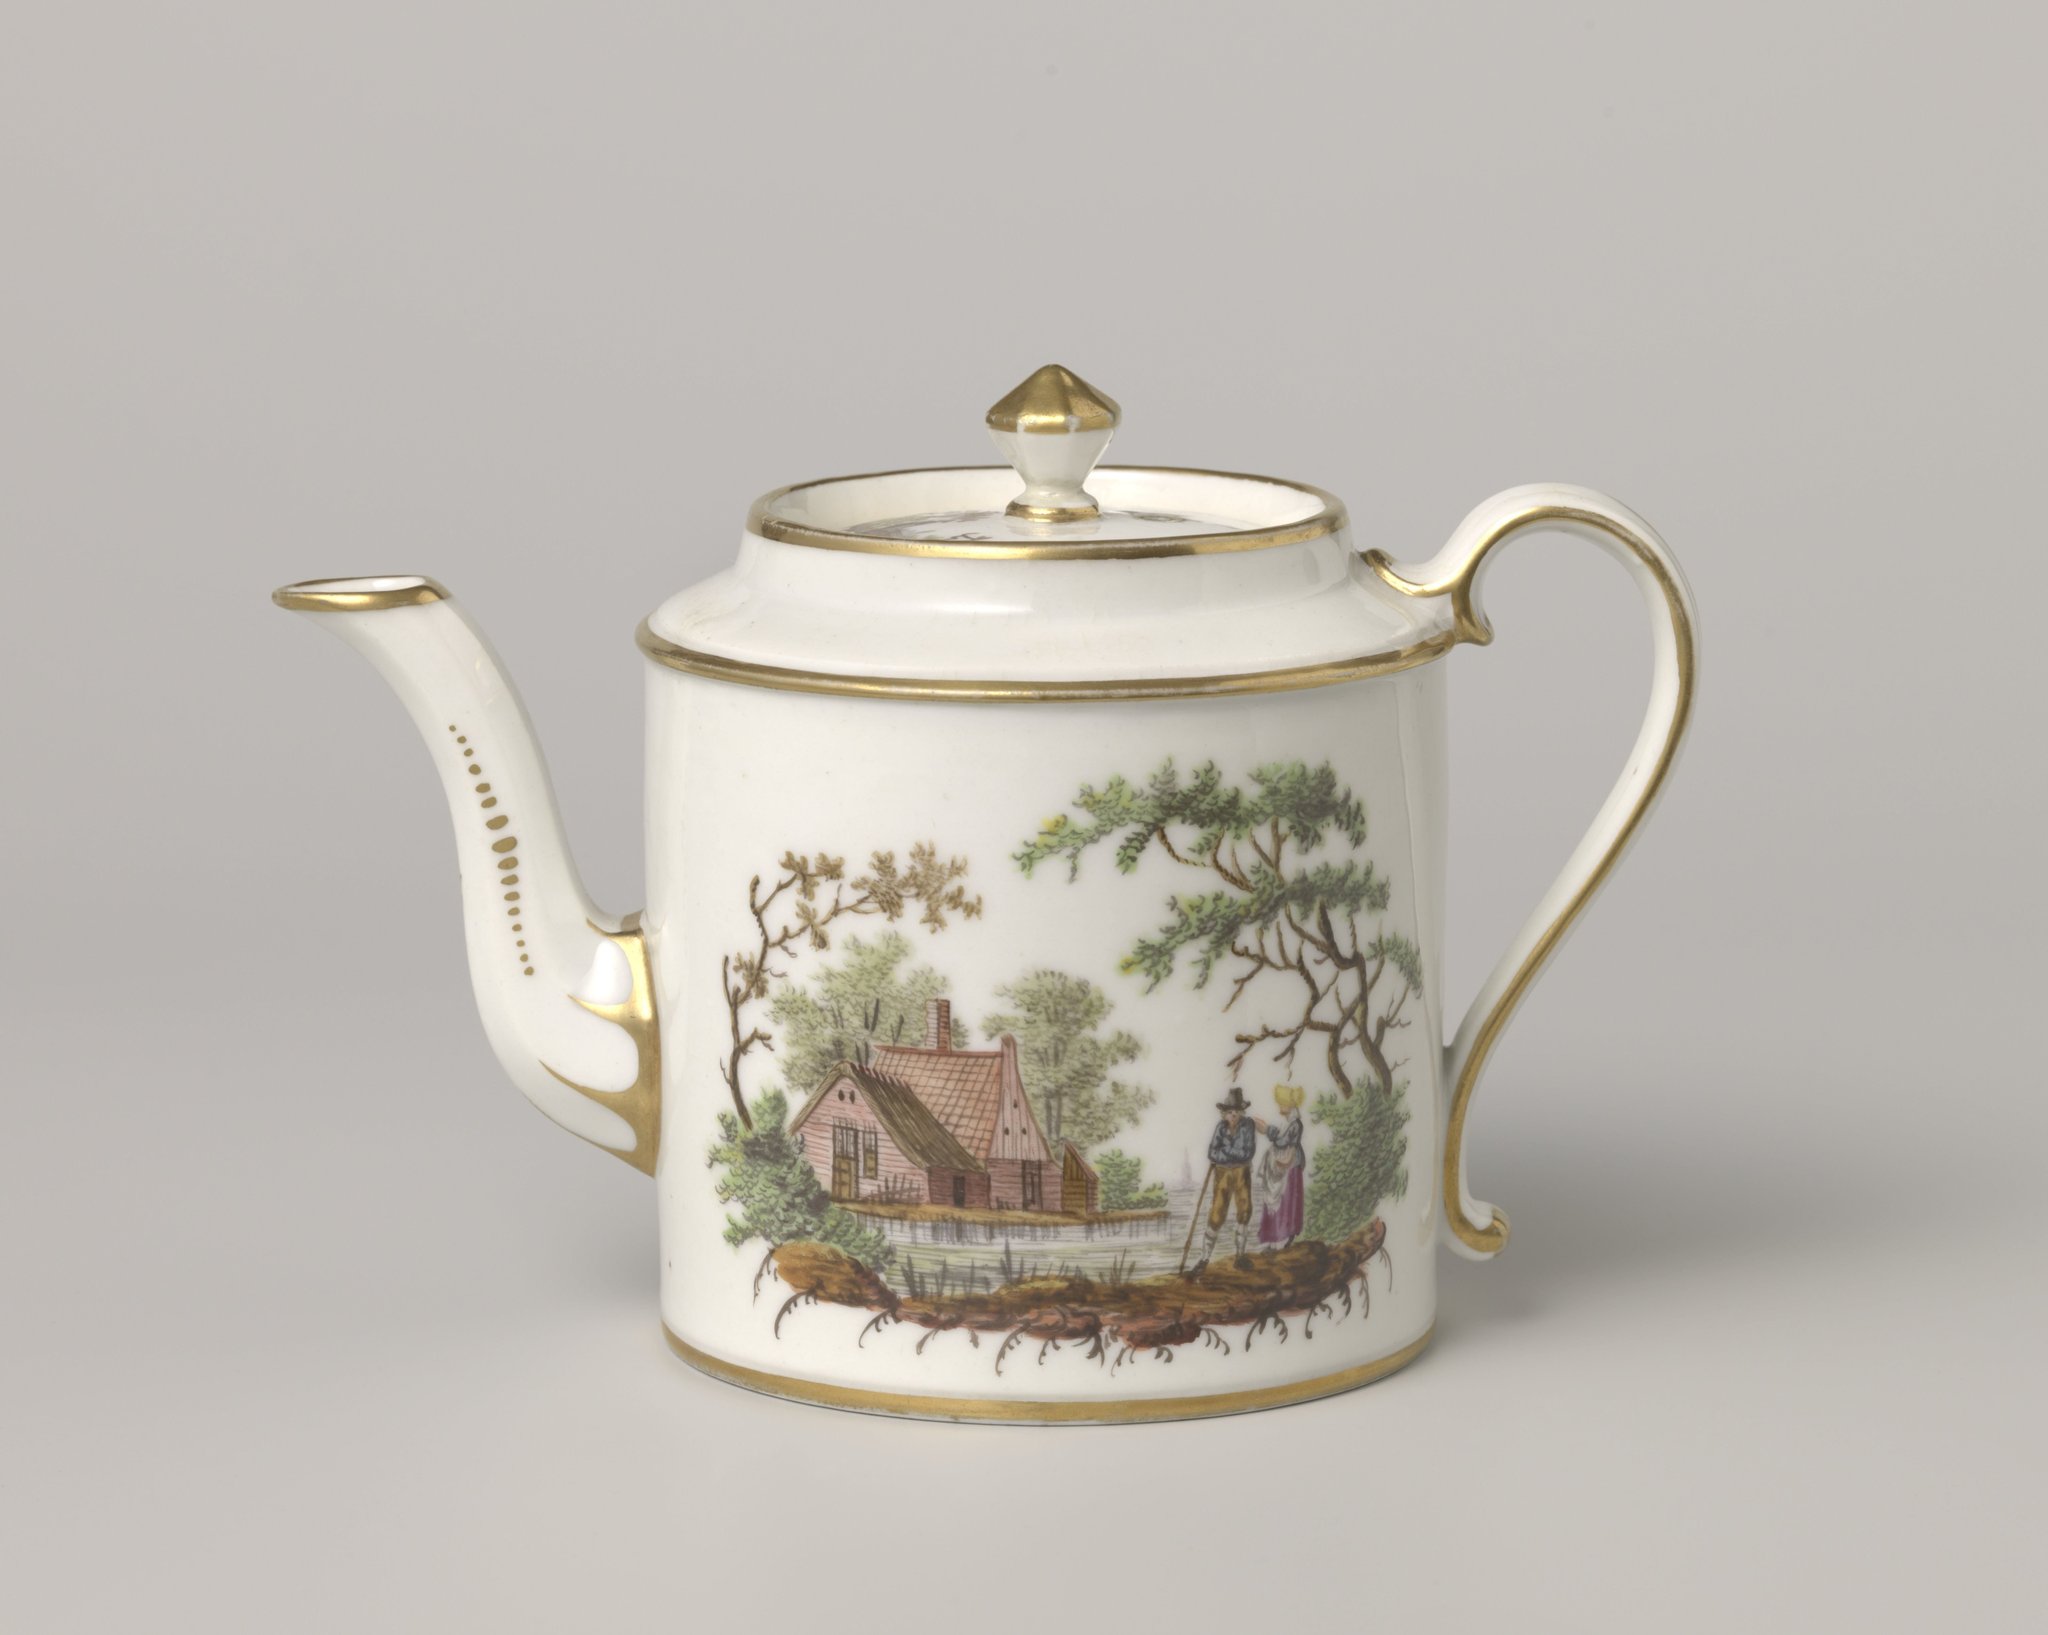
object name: teapot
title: Theepot, beschilderd met een landschap met huizen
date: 1809-1814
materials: porcelain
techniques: painted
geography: nieuwer-amstel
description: Tea service. Porcelain. Ouder-Amstel or Nieuwer-Amstel, c. 1805 - 1810. Factory of Nicolaas Gerard Dommer. On loan from the Koninklijk Oudheidkundig Genootschap.